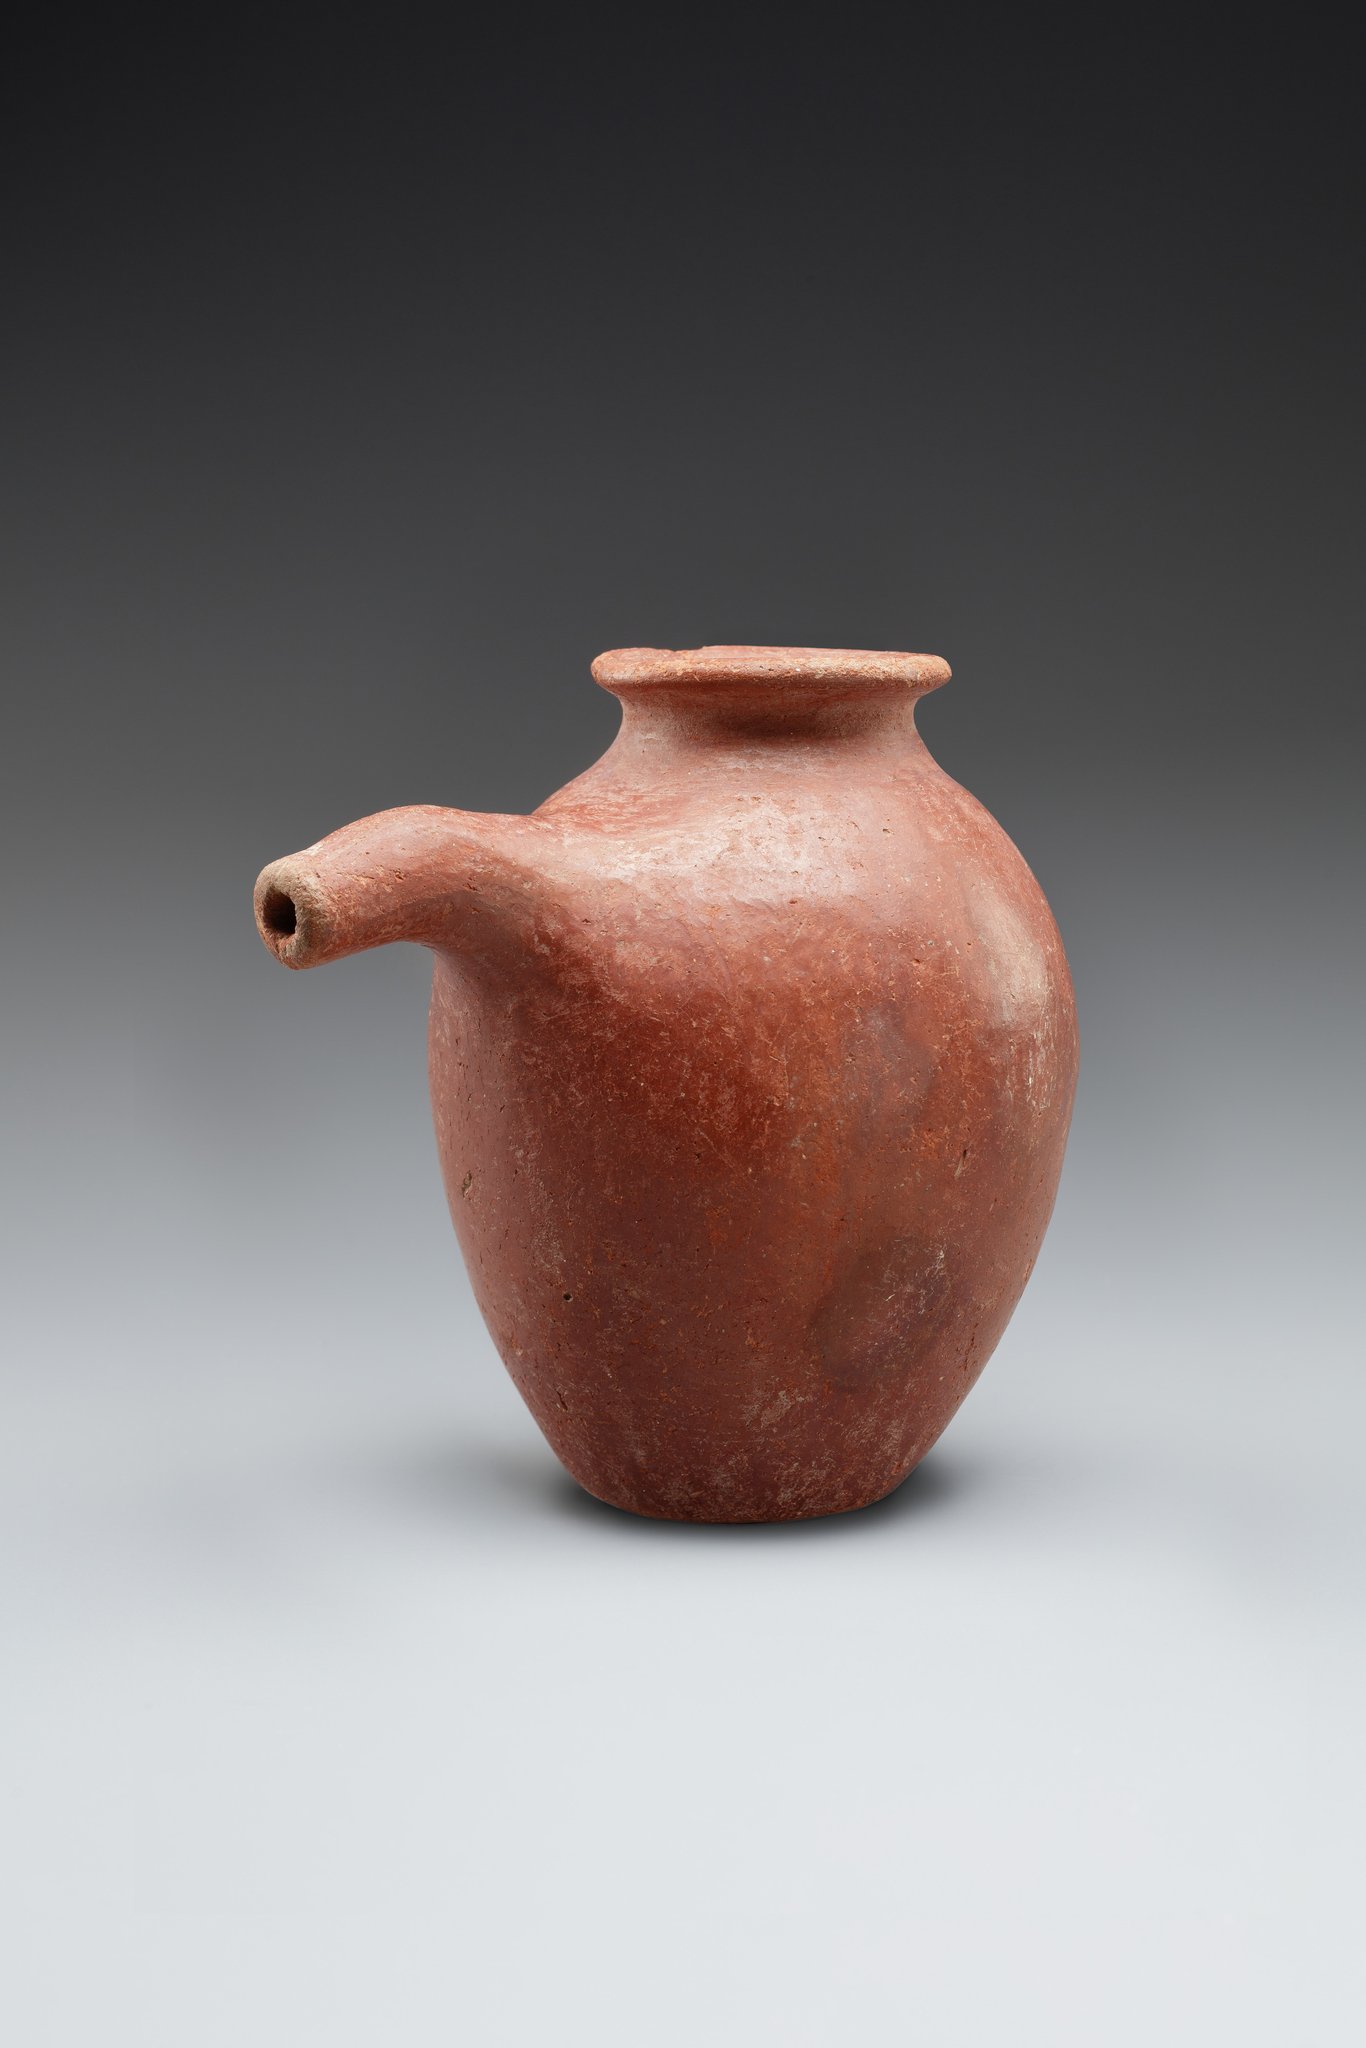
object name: jar, red polished ware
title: Red polished ware jar with a spout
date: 3500 BCE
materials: pottery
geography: egypt